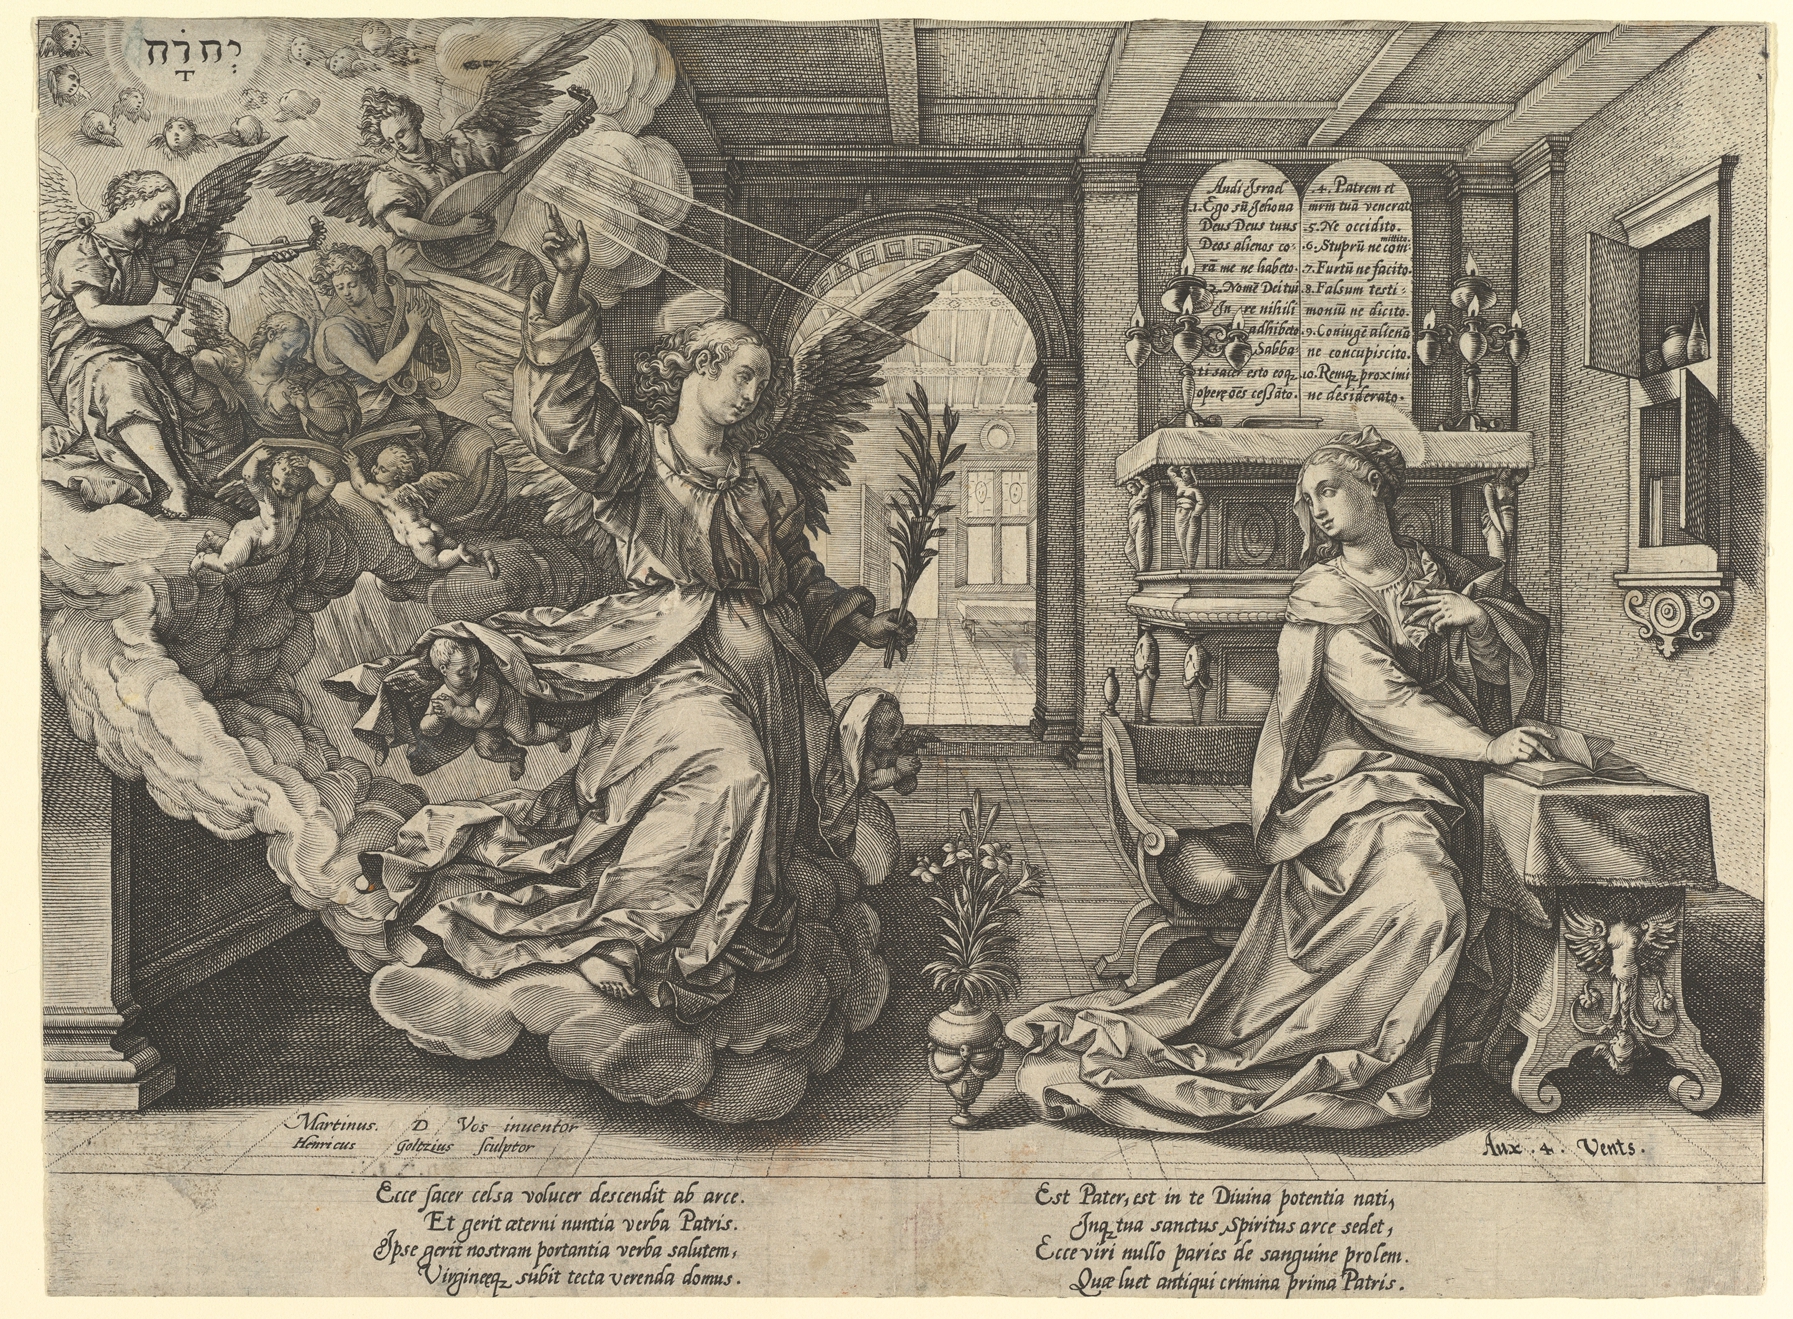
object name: print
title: Annunciation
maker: hendrick goltzius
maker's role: artist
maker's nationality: netherlandish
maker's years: 1558-1617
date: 1594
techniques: engraving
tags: angels,virgin mary,annunciation,musicians